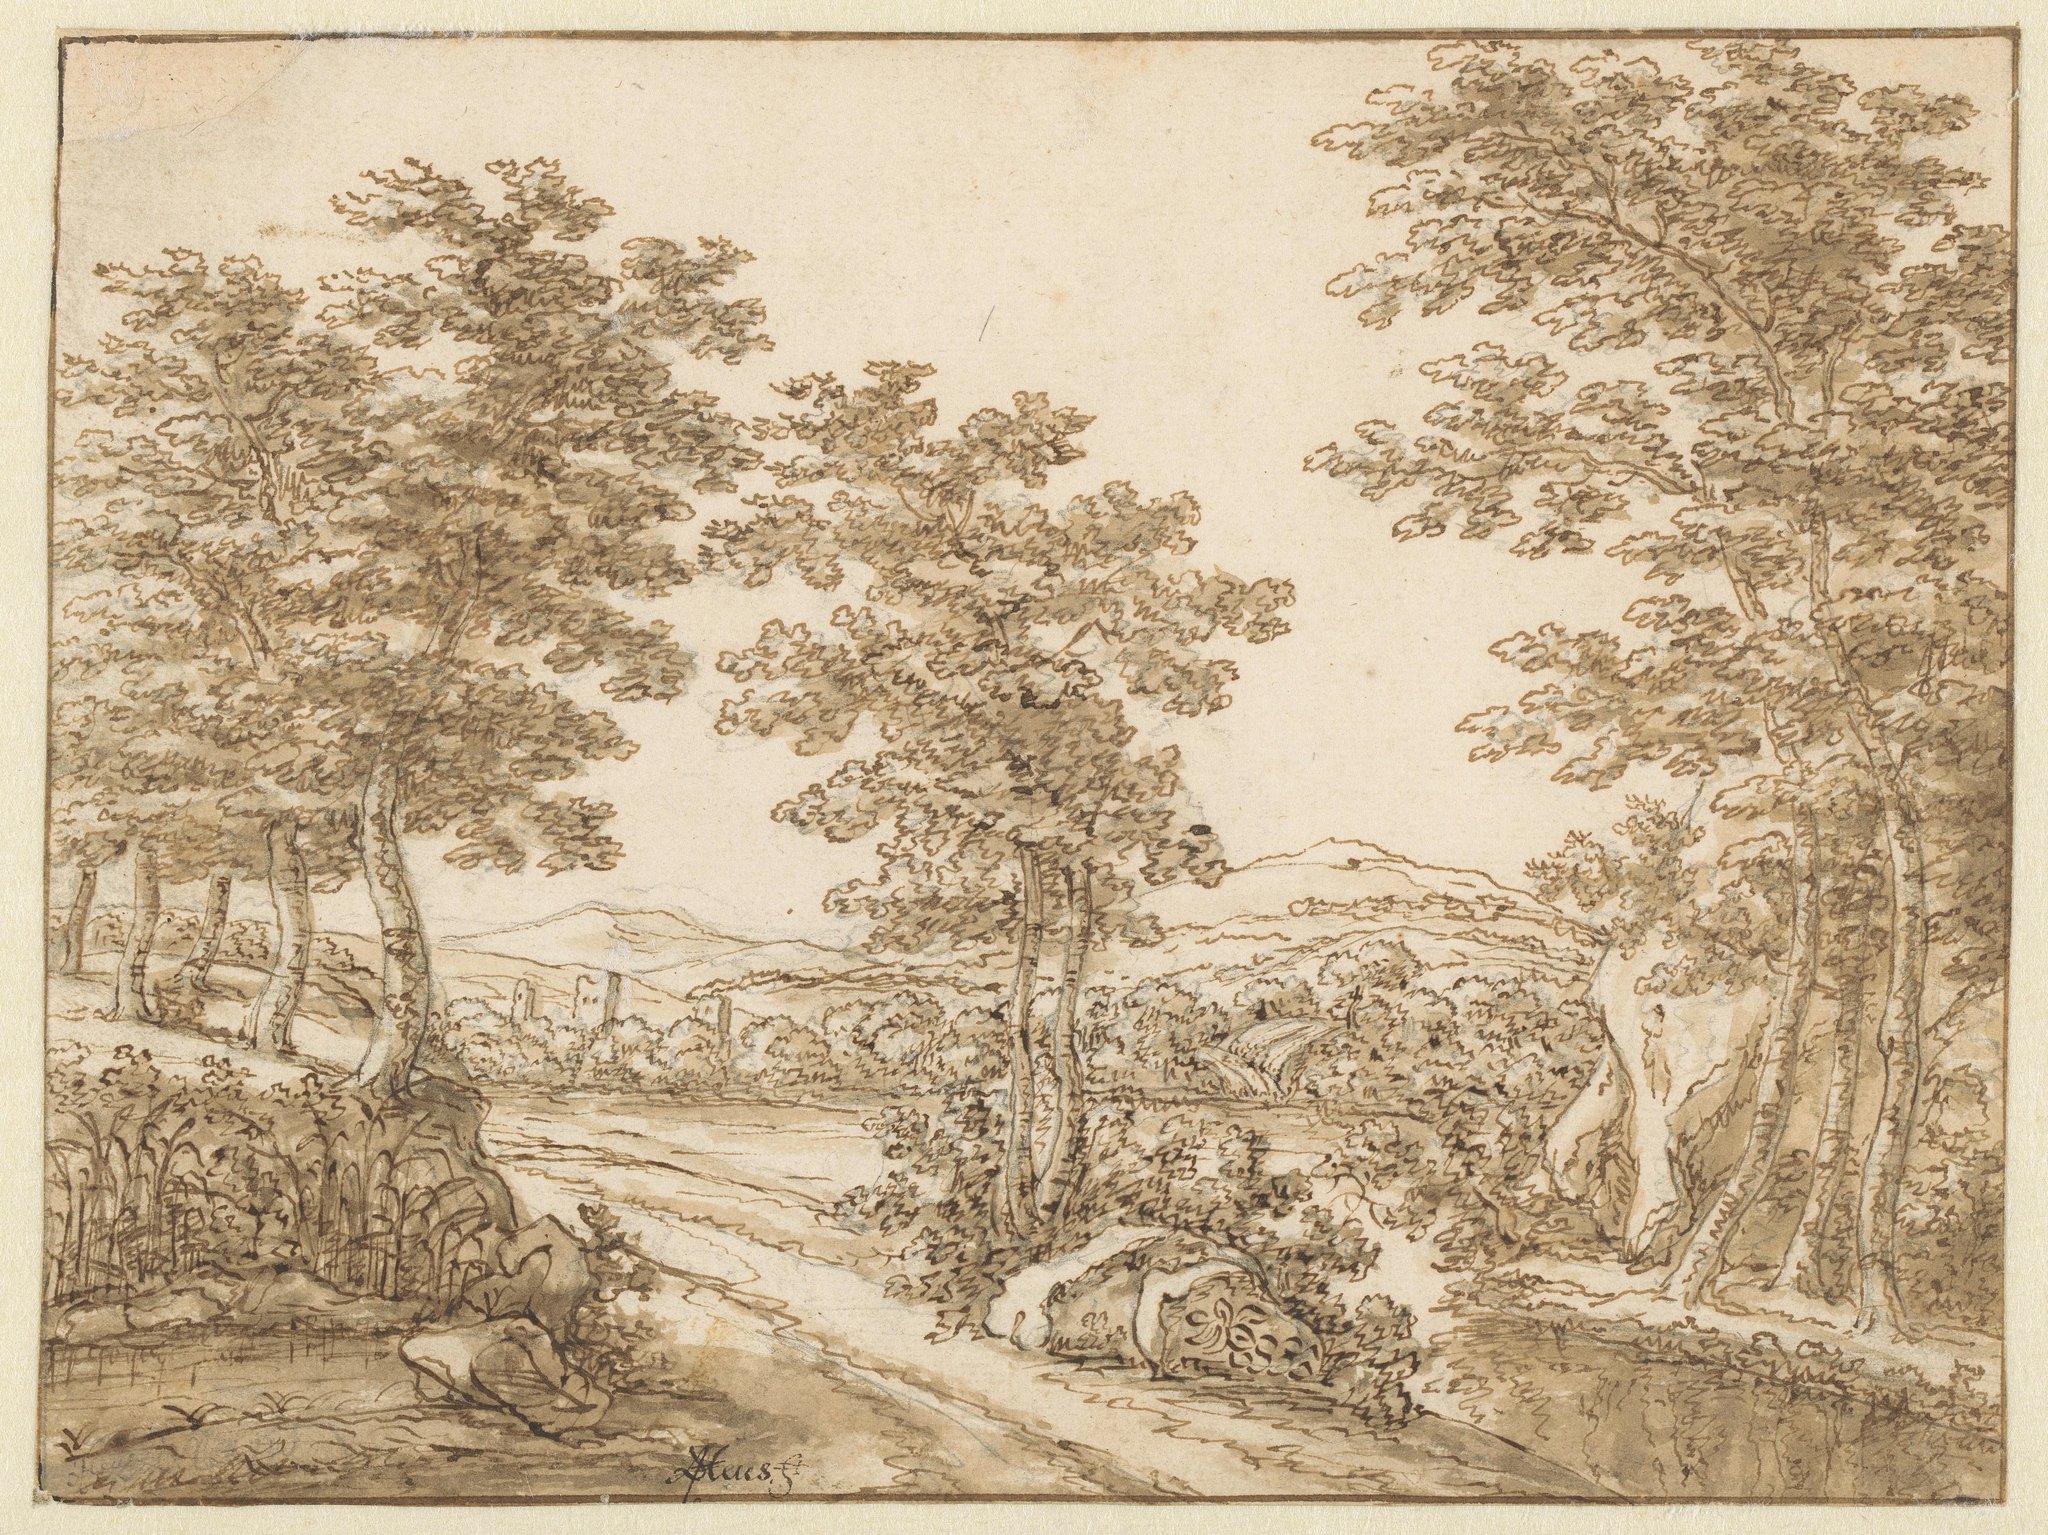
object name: drawing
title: Heuvelachtig boomrijk landschap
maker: willem de heusch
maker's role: draughtsman, painter, print maker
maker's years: 1625-1692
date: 1635-1692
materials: ink, paper, pencil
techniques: brush, pen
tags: low hill country